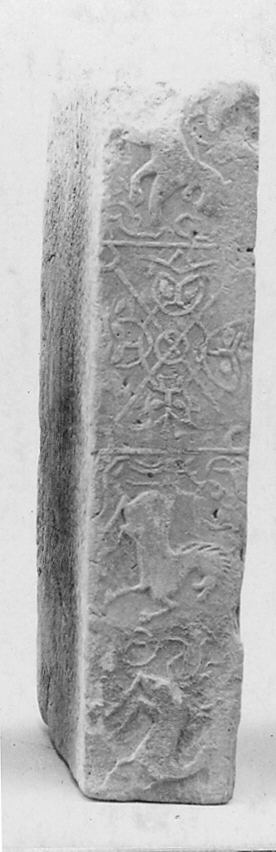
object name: tile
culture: chinese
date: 221 BCE-220 CE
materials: earthenware